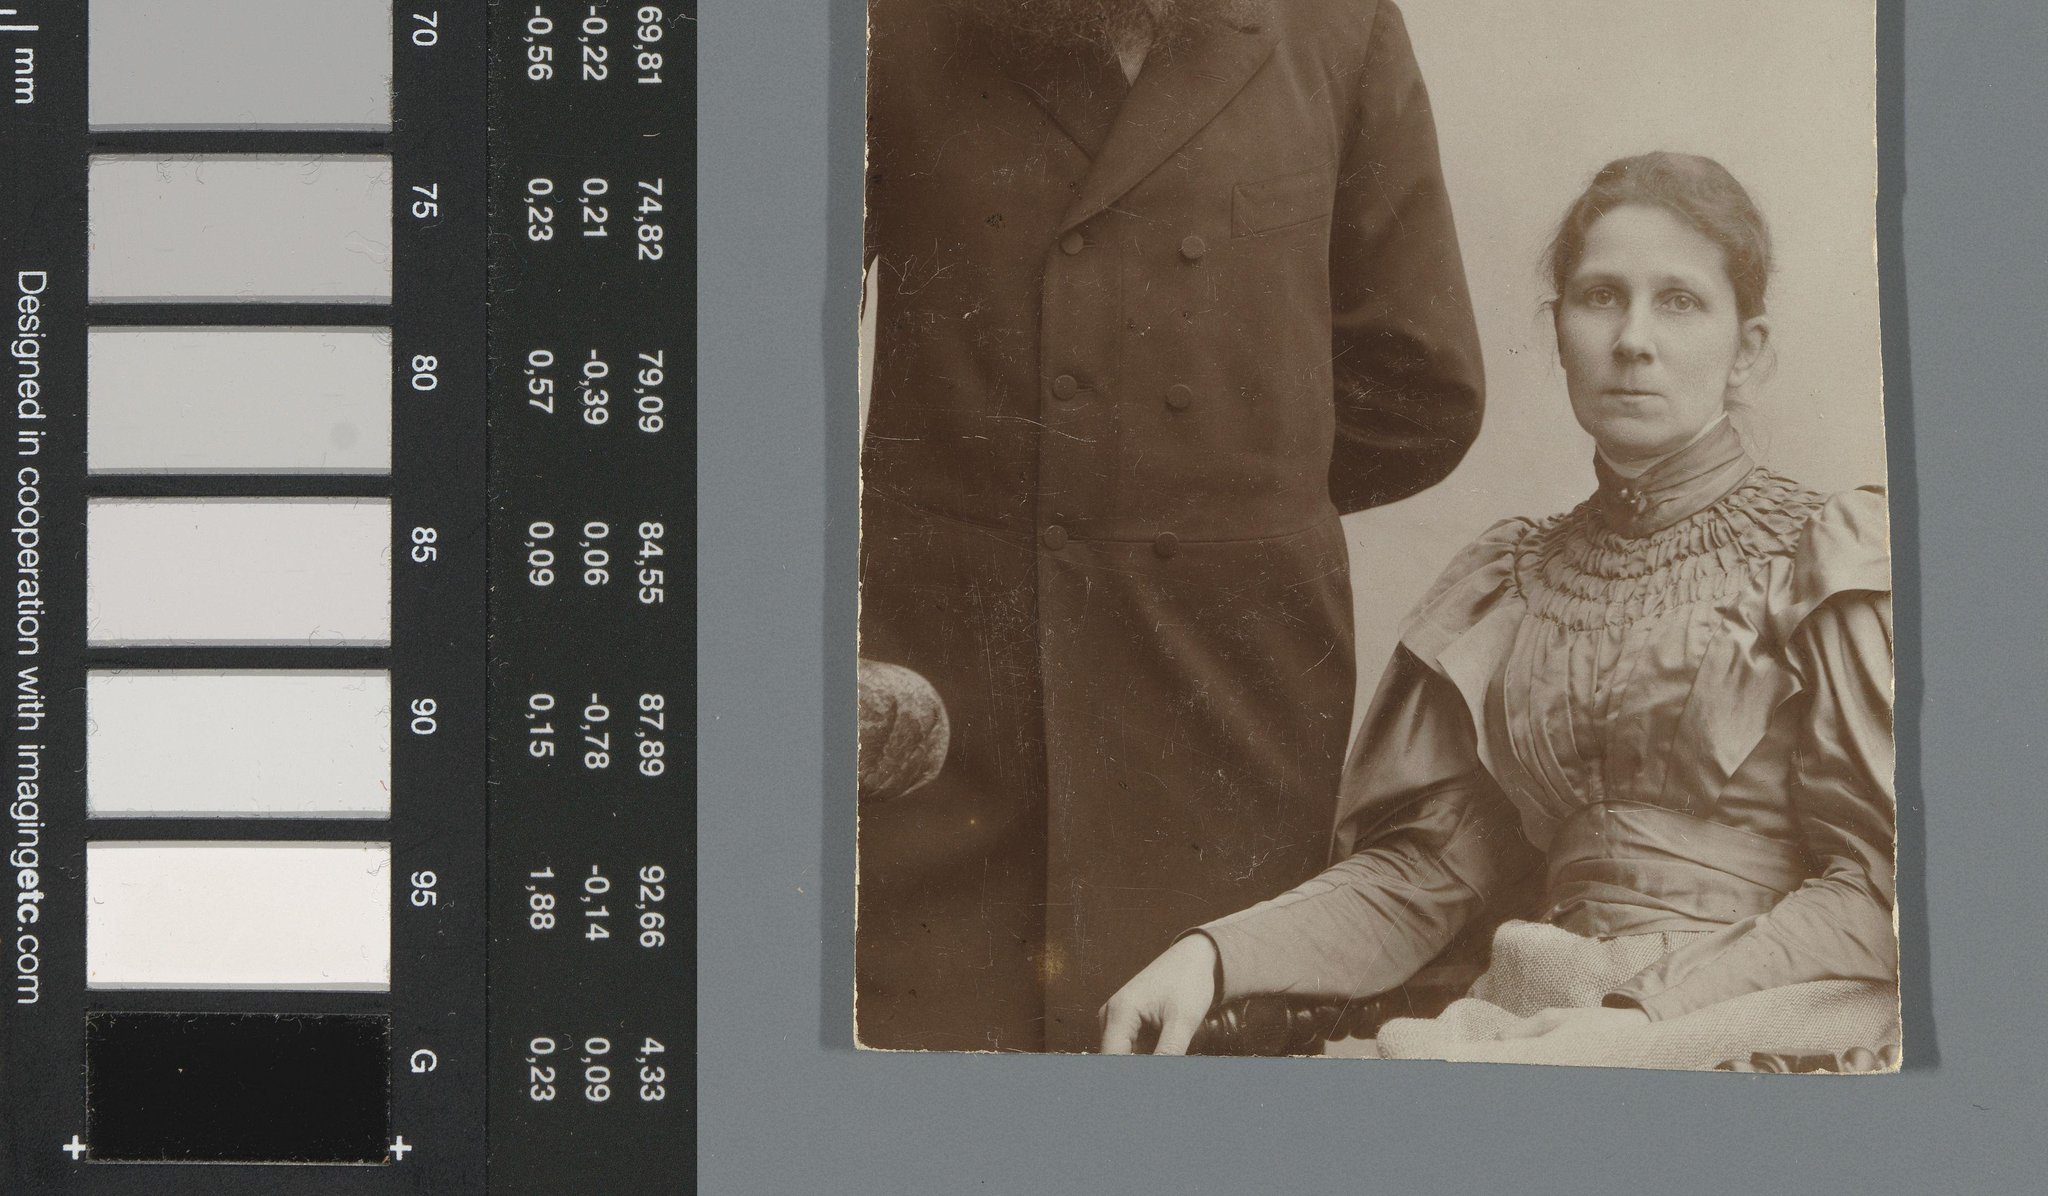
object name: photograph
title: Portret van Francis Marius Baron van Lynden en Joanna van Lynden-Teding van Berkhout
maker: Anonymous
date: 1876-1890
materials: photographic support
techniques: photography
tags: haarlem, historical persons - bb - woman, historical persons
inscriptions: annotation: ‘F.M. Baron van Lynden en Joanna v Lynden-TvB’